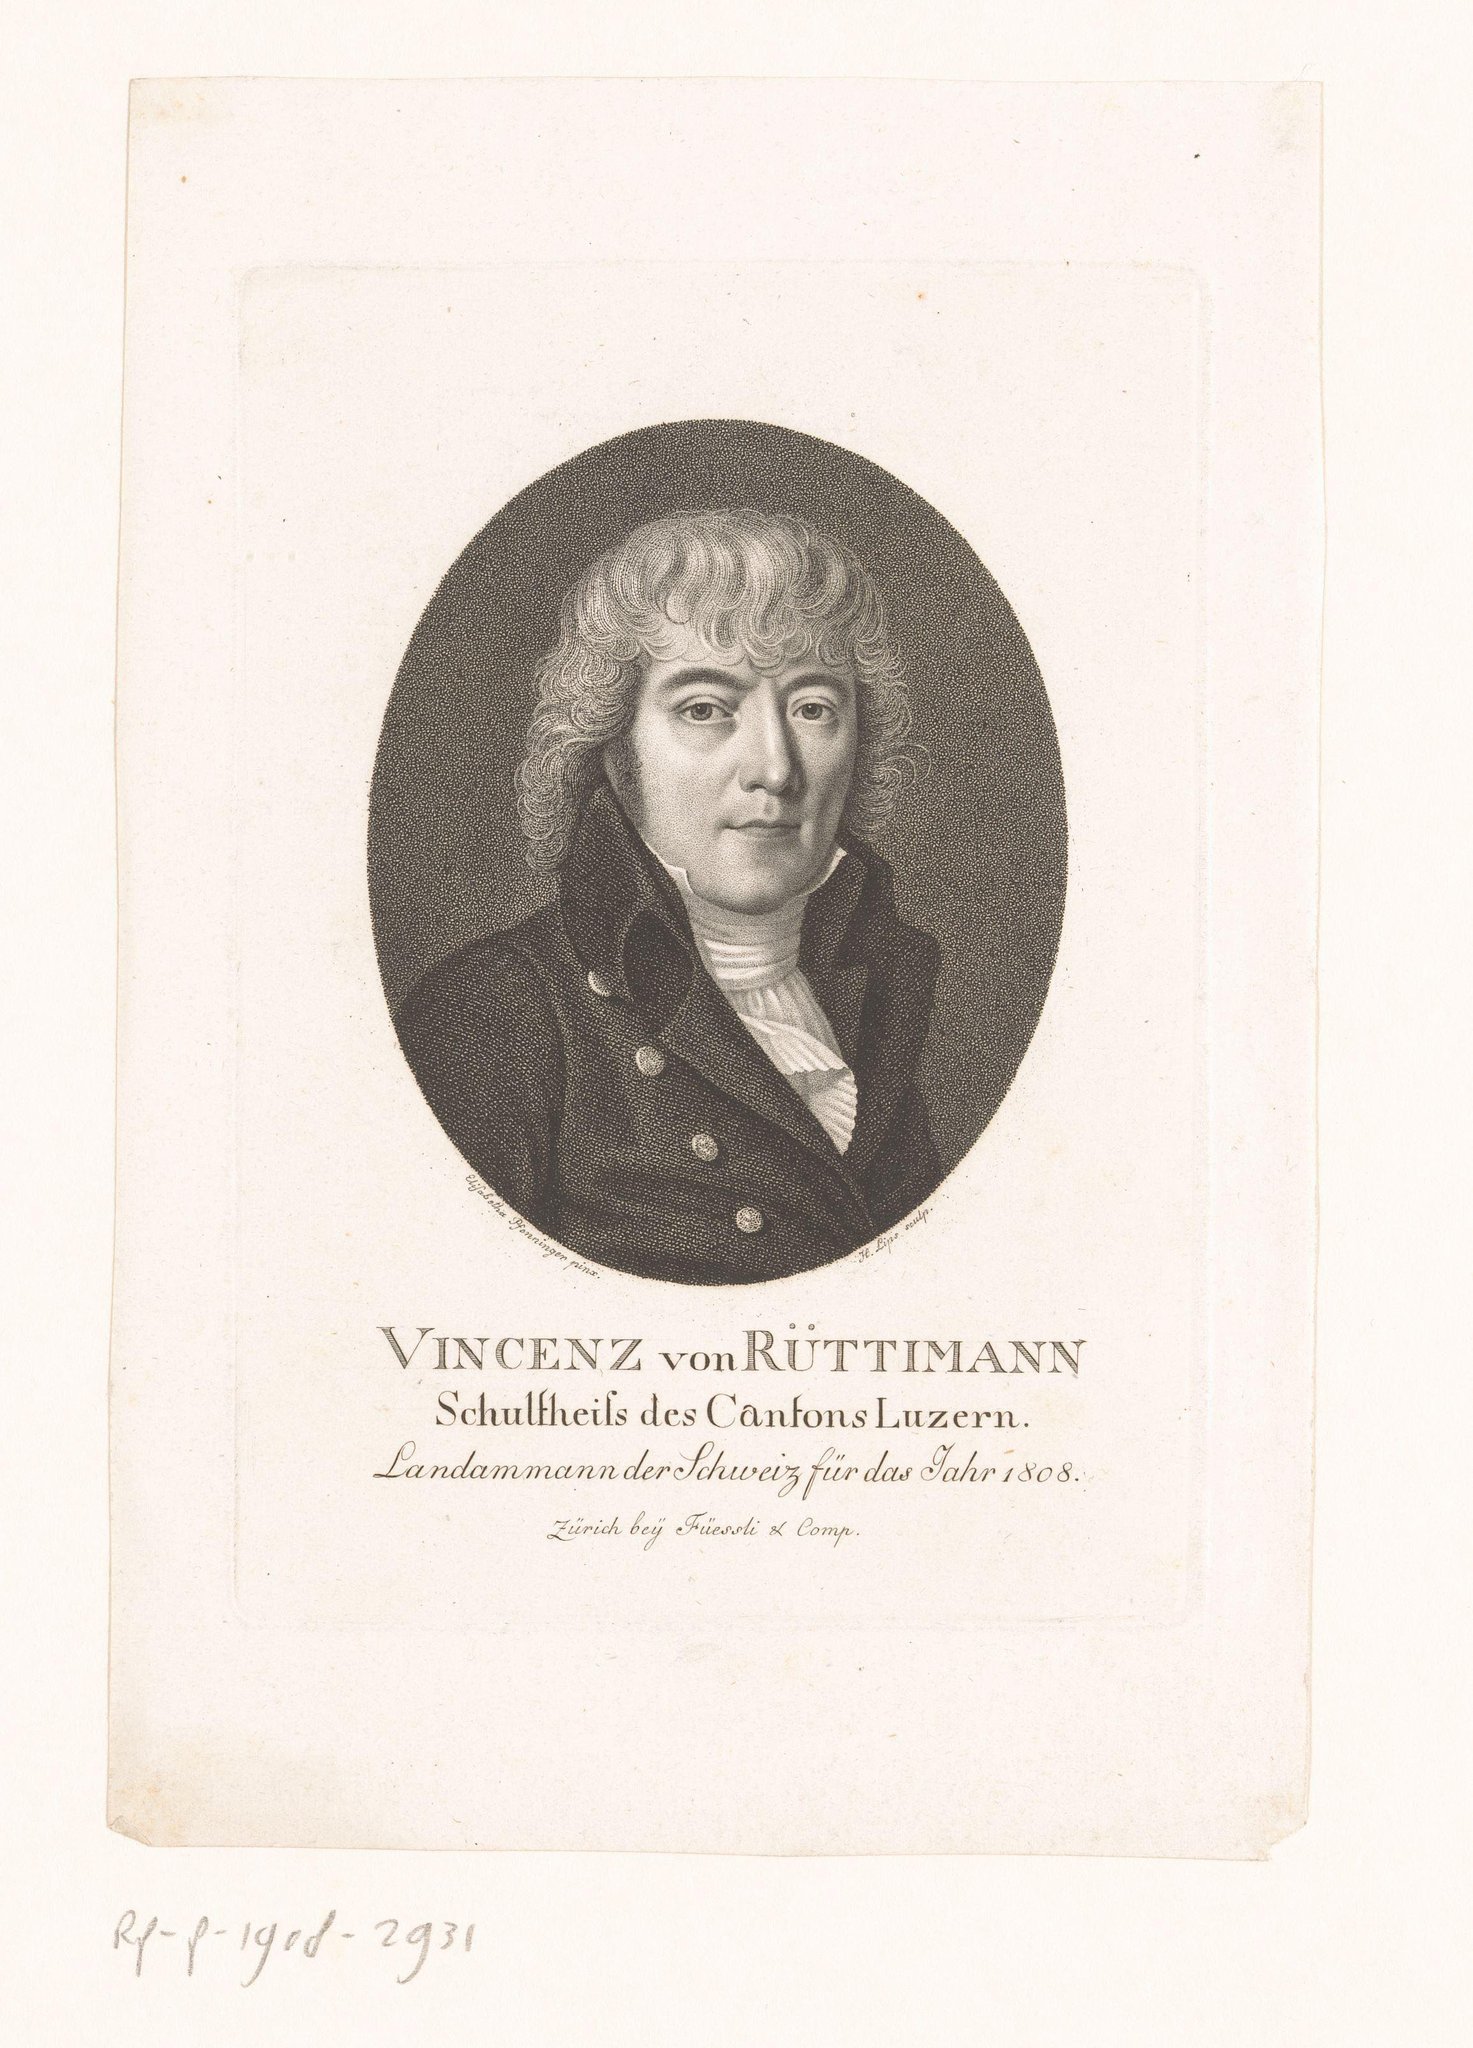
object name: print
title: Portret van Vincenz Rüttimann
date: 1808-1817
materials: paper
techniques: engraving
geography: zurich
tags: historical persons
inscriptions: collector's mark: Lugt 2228